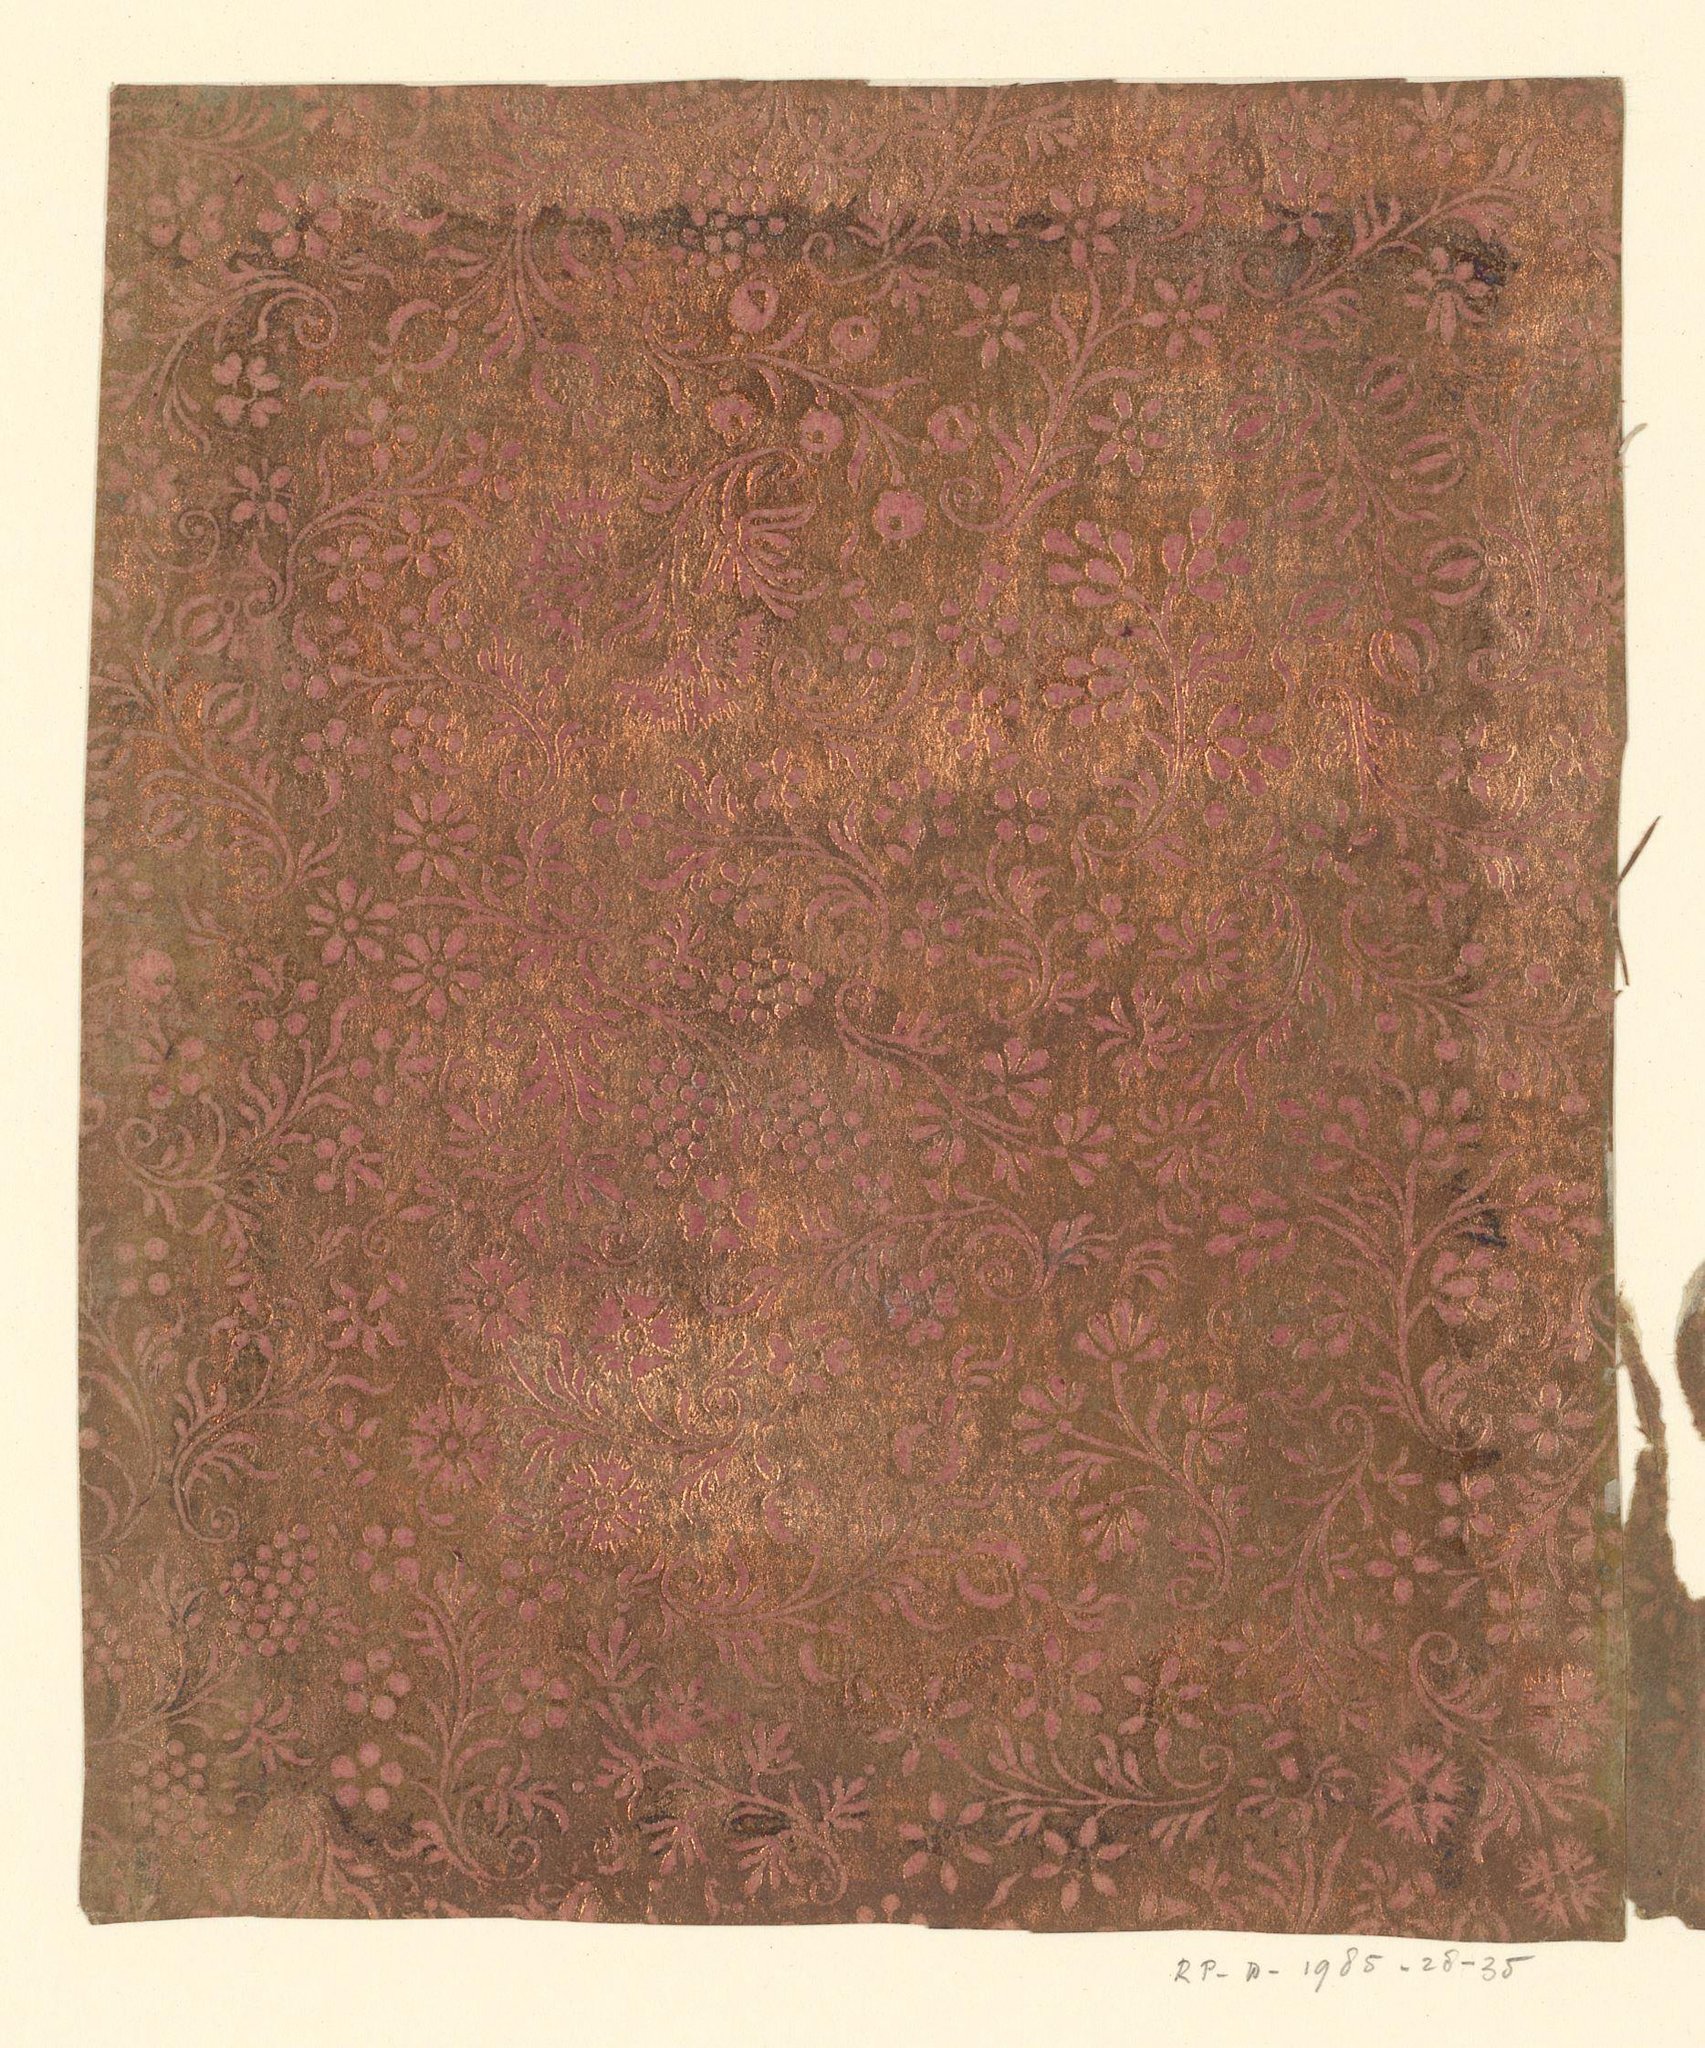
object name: brocade paper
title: Blad met bloemen met vruchten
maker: Anonymous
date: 1700-1850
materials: gold leaf, paper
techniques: relief print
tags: ornament derived from plant forms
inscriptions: collector's mark: Lugt 2228, collector's mark: Lugt 2760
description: Blad met bloemen met vruchten. Helft van een omslag (voor de andere helft zie: RP-D-1985-28-36).